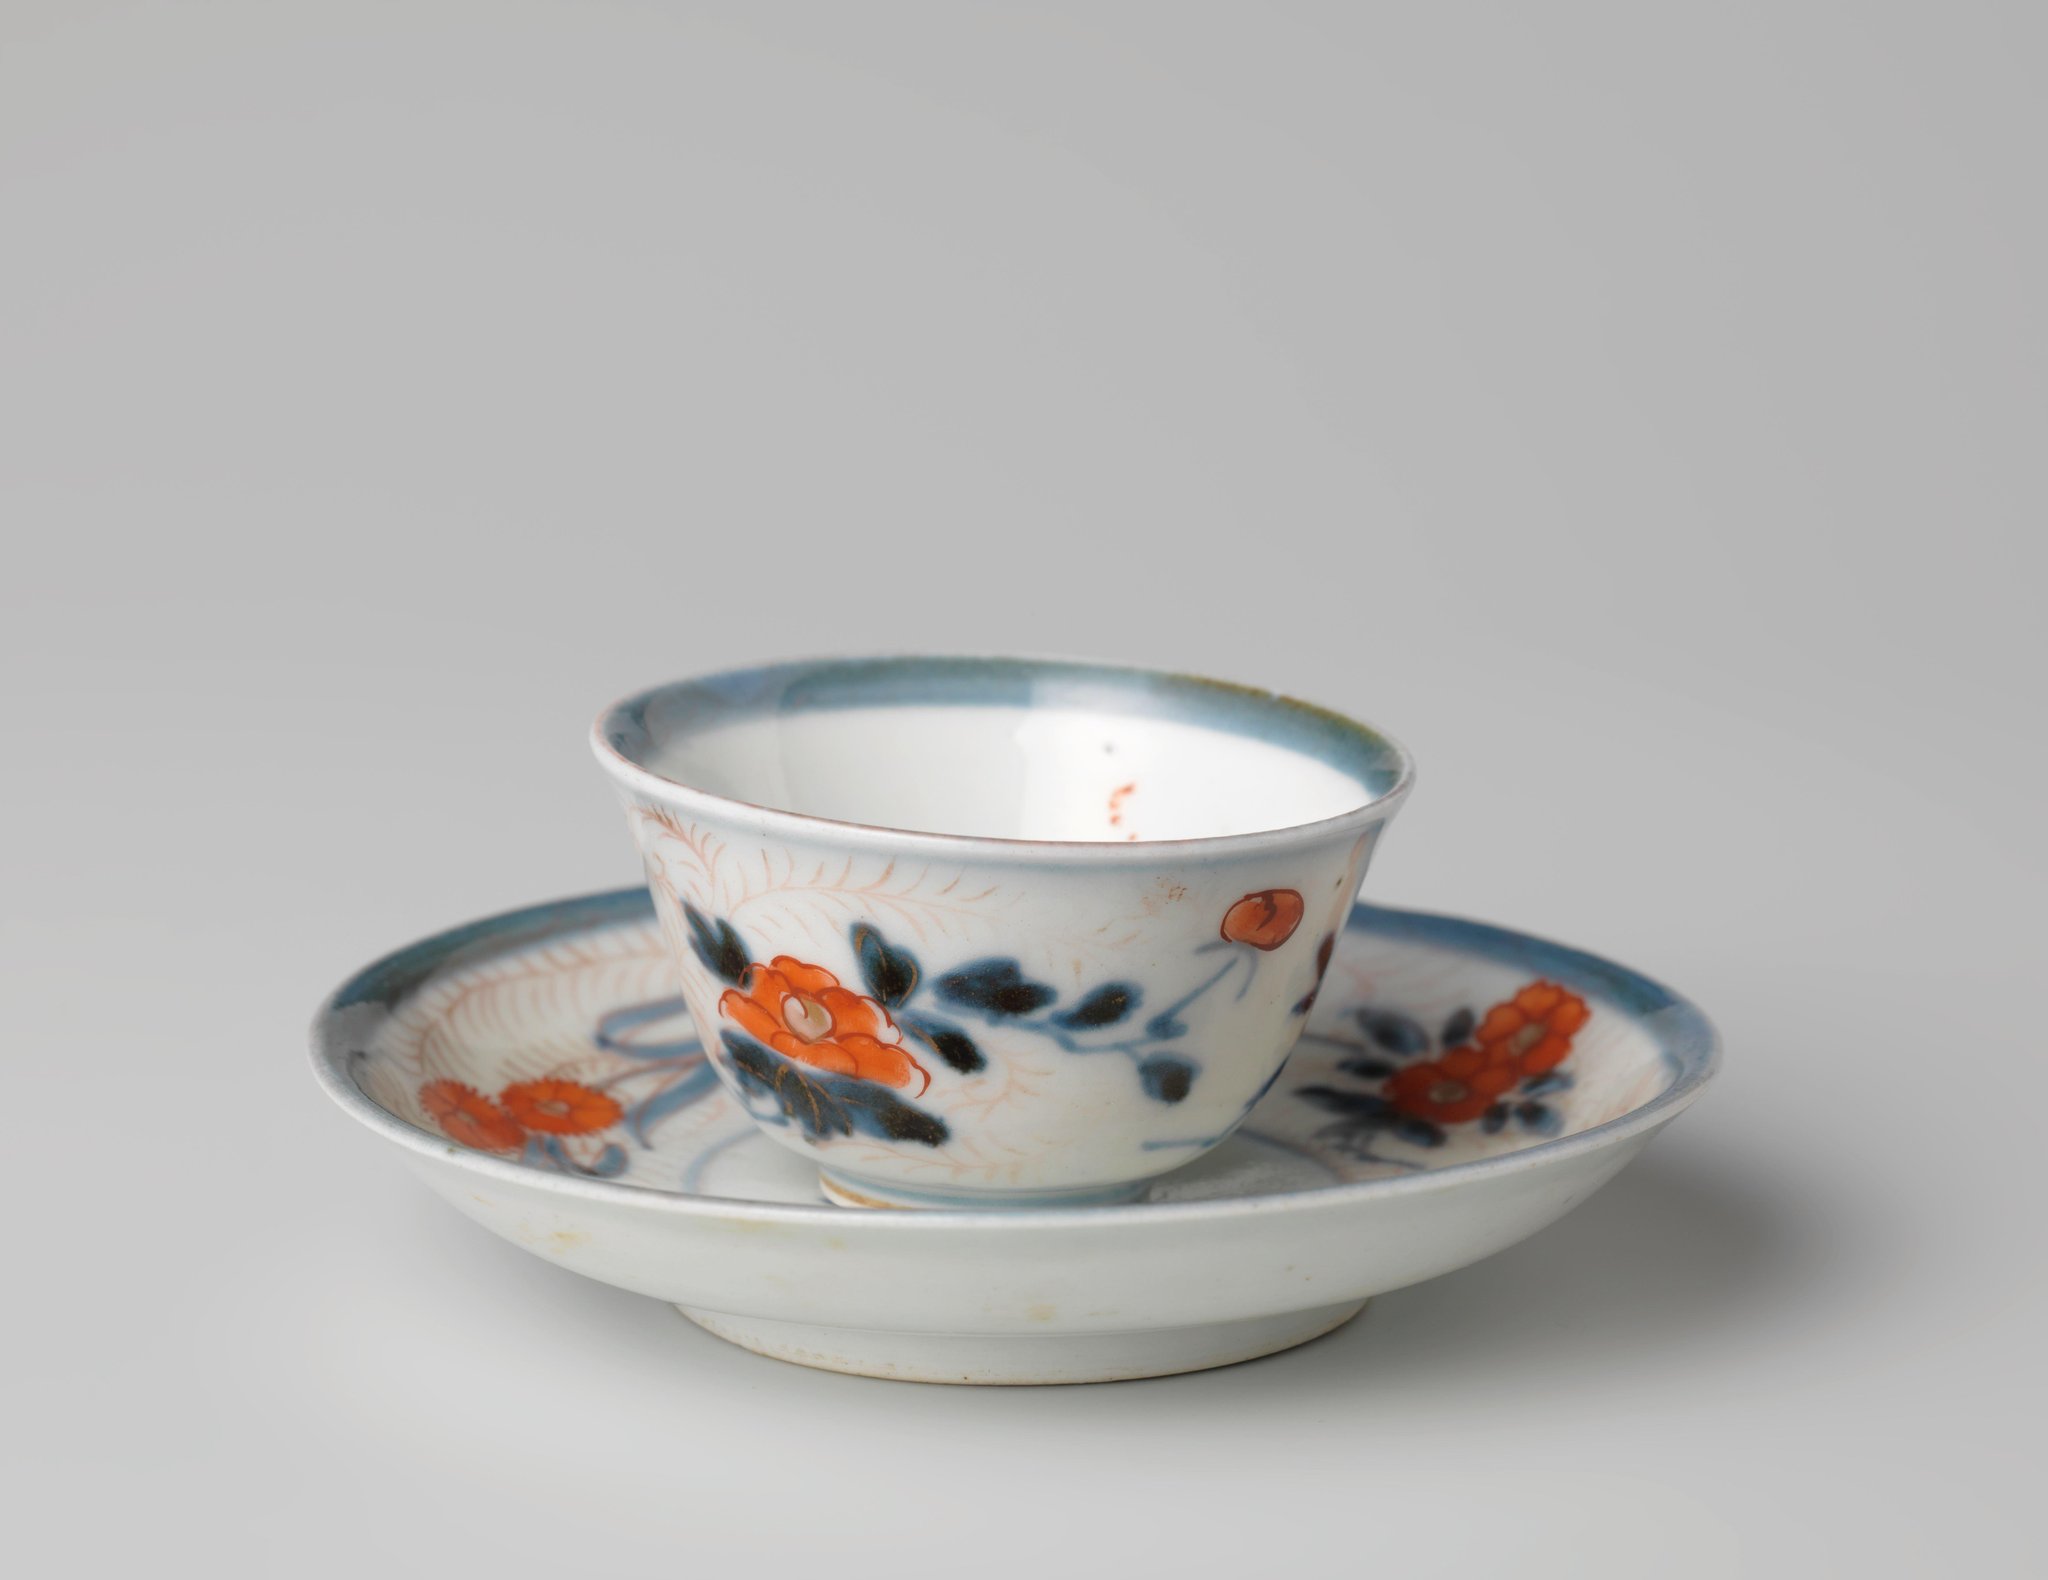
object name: kop en schotel, kop en schotel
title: Bell-shaped cup and saucer with flower sprays and foliate scrolls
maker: Anonymous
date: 1800-1824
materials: cobalt, glaze, gold, paint, porcelain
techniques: firing, gilding, turning, vitrification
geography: japan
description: Klokvormige kop en schotel van porselein, beschilderd in onderglazuur blauw en op het glazuur rood en goud. Op het plat van de schotel een lotusrank in een medaillon. Om het medaillon bladranken met daartussen drie bloemtakken. De binnenrand is blauw. De kop met dezelfde decoratie. Imari.